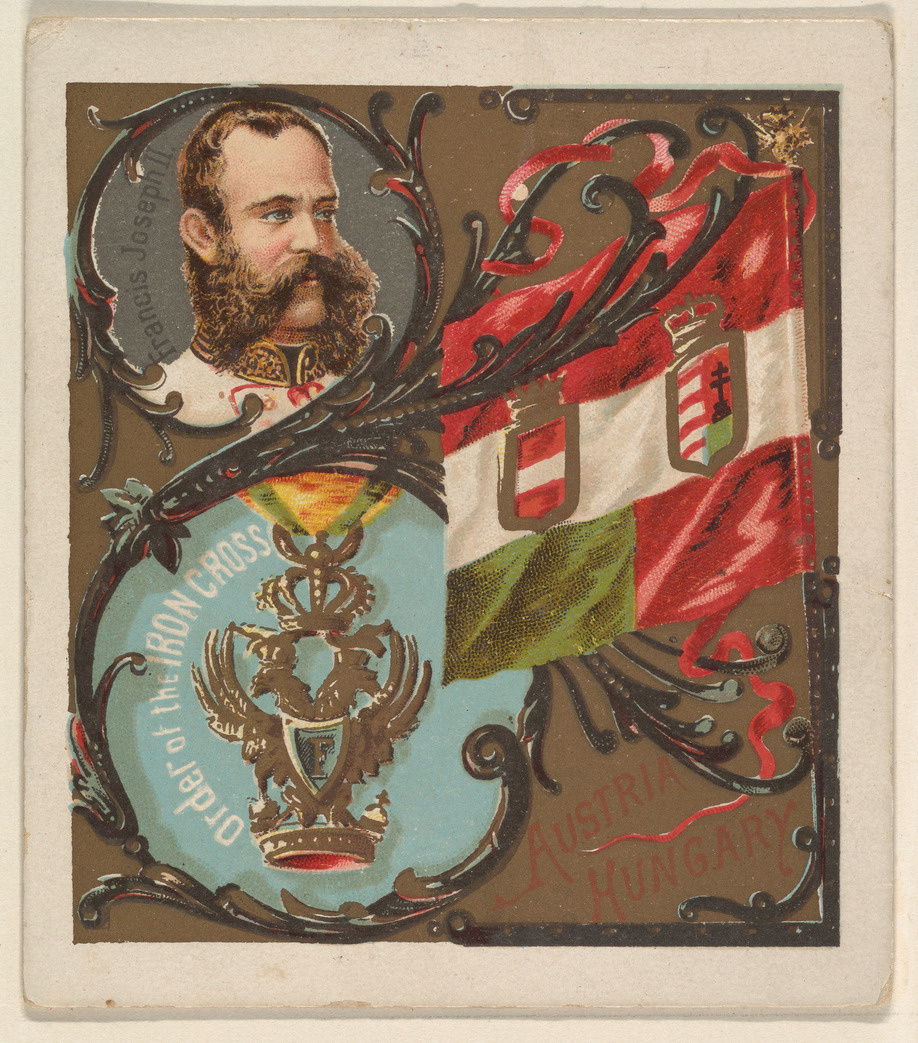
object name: print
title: Austria Hungary, from the International Cards series (N238), issued by Kinney Bros.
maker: kinney brothers tobacco company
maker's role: publisher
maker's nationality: american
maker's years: 1869-2011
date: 1888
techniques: color lithograph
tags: men,flags